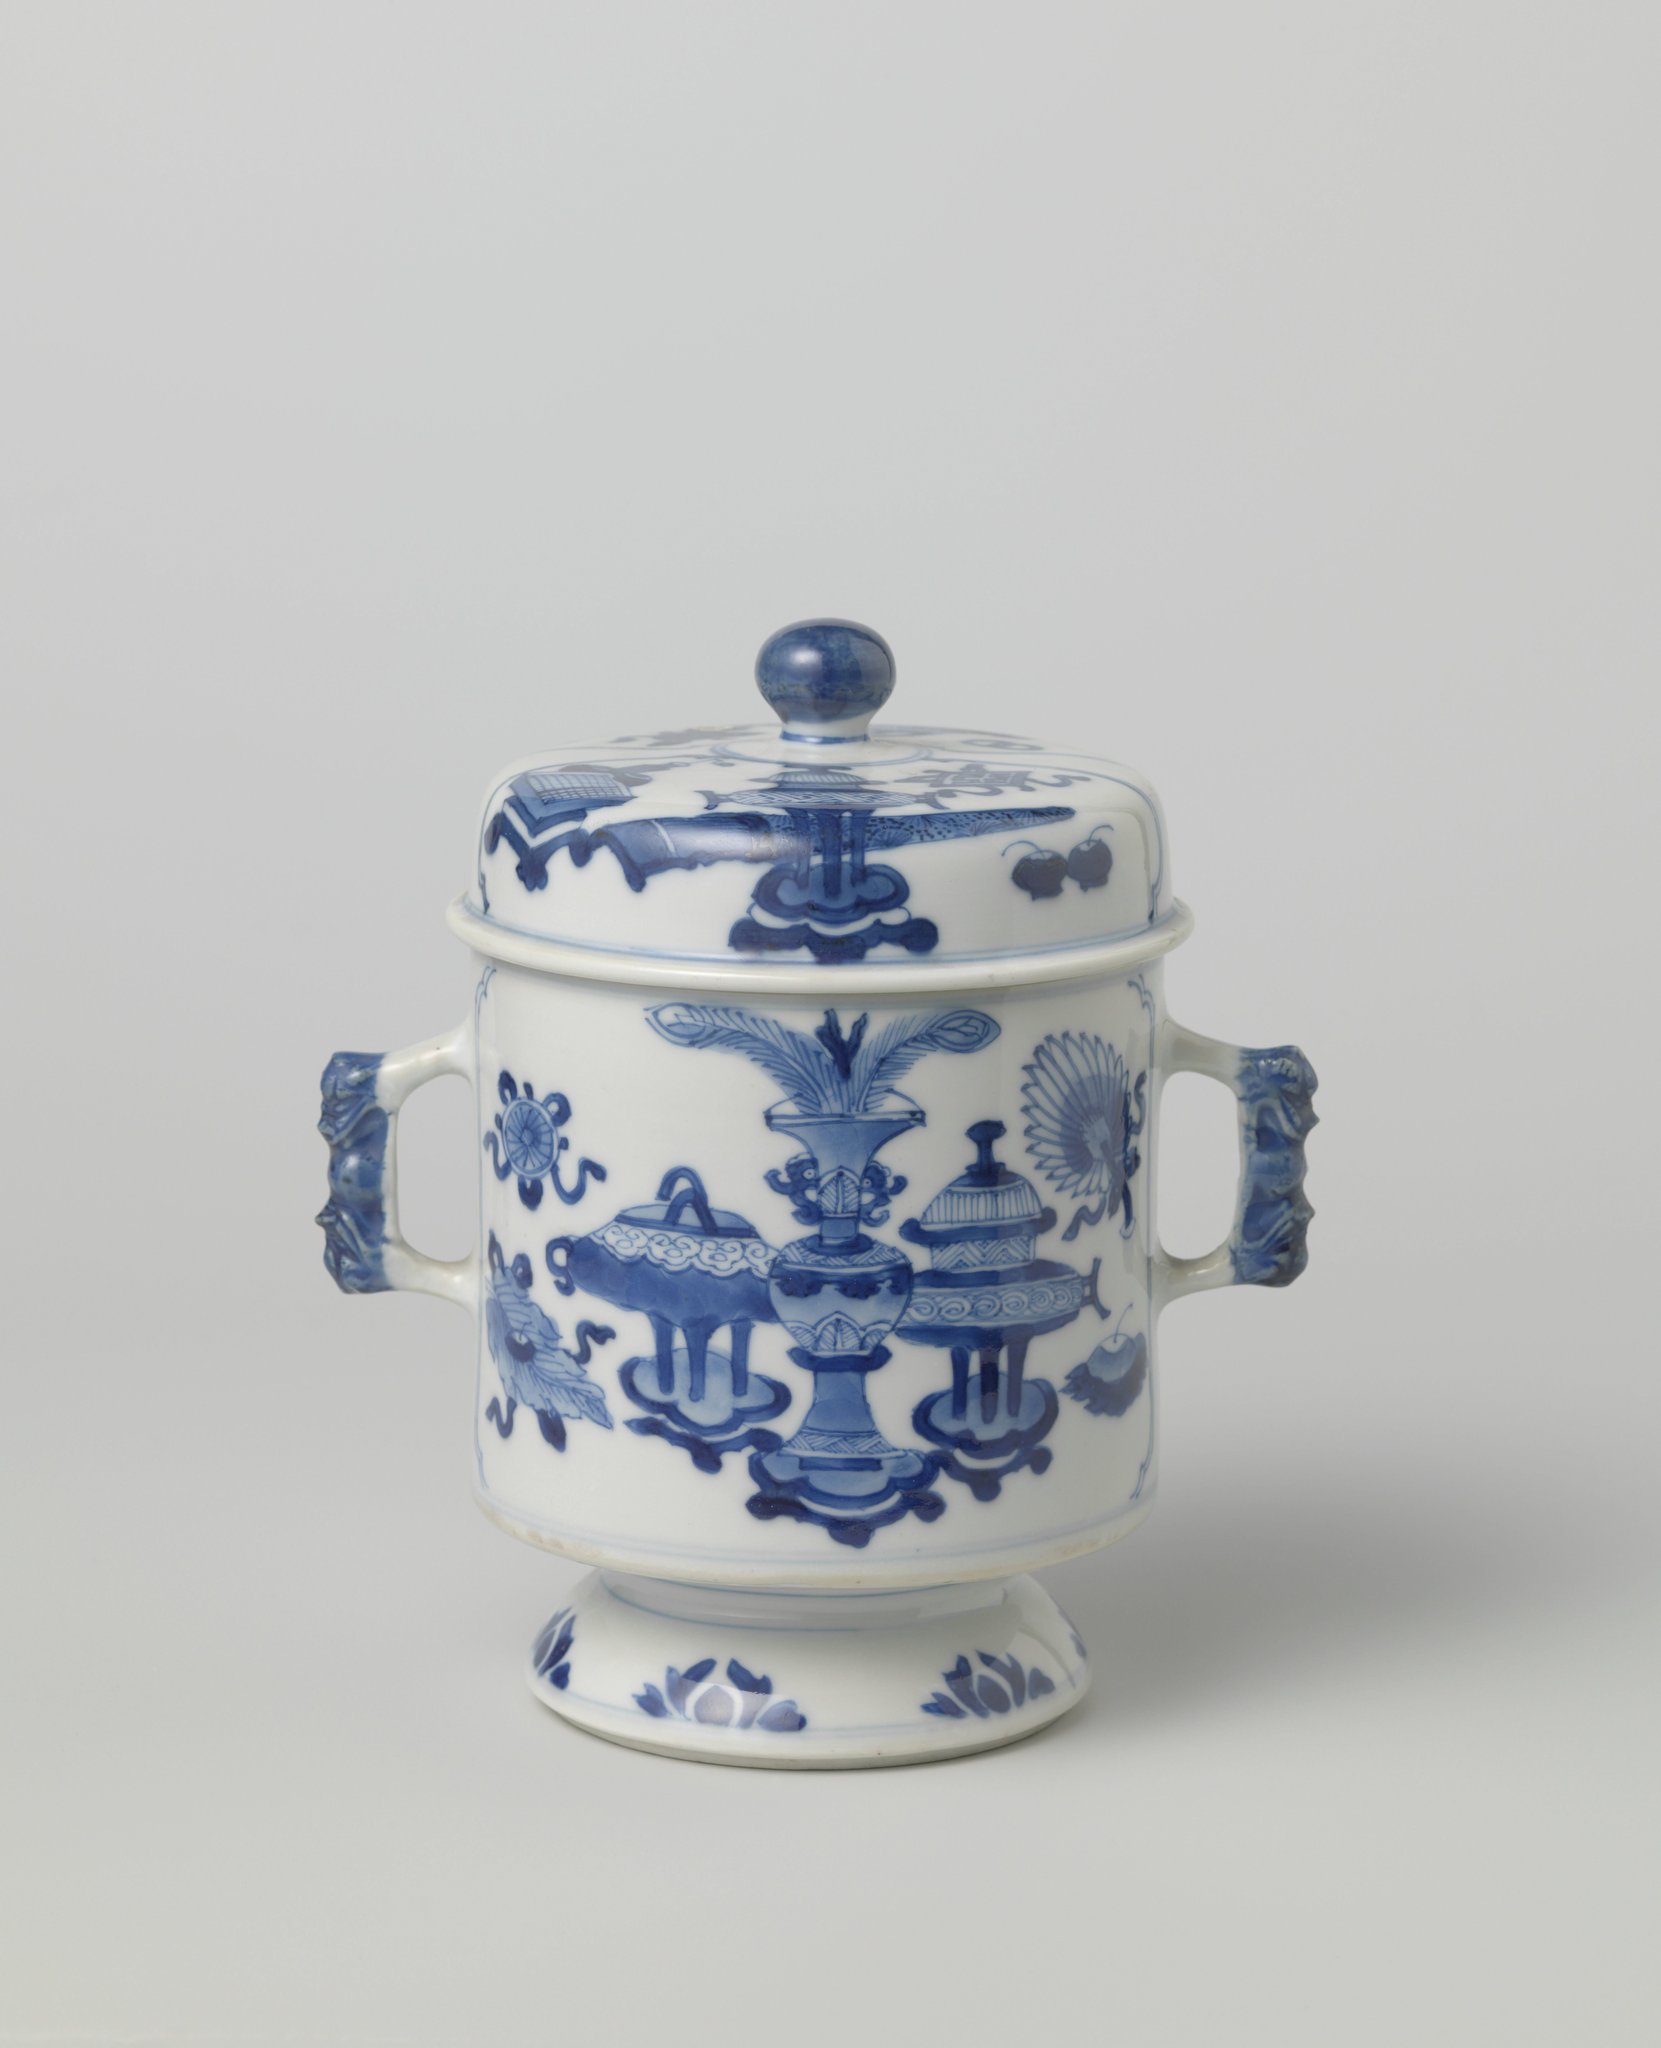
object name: covered jar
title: Cylindrical covered jar on foot with precious objects and antiquities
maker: Anonymous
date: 1700-1724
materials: cobalt, glaze, paint, porcelain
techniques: firing, forming, turning, vitrification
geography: china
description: Cilindrische dekselpot van porselein met twee opstaande oren met monsterkoppen, beschilderd in onderglazuur blauw. Op de wand twee cartouches met kostbaarheden (parel, artemisiablad, ruit, muzieksteen) en antiquiteiten (driepoot, vaas, boeken); rond de voet een band met halve lotusbloemen. Blauw-wit.